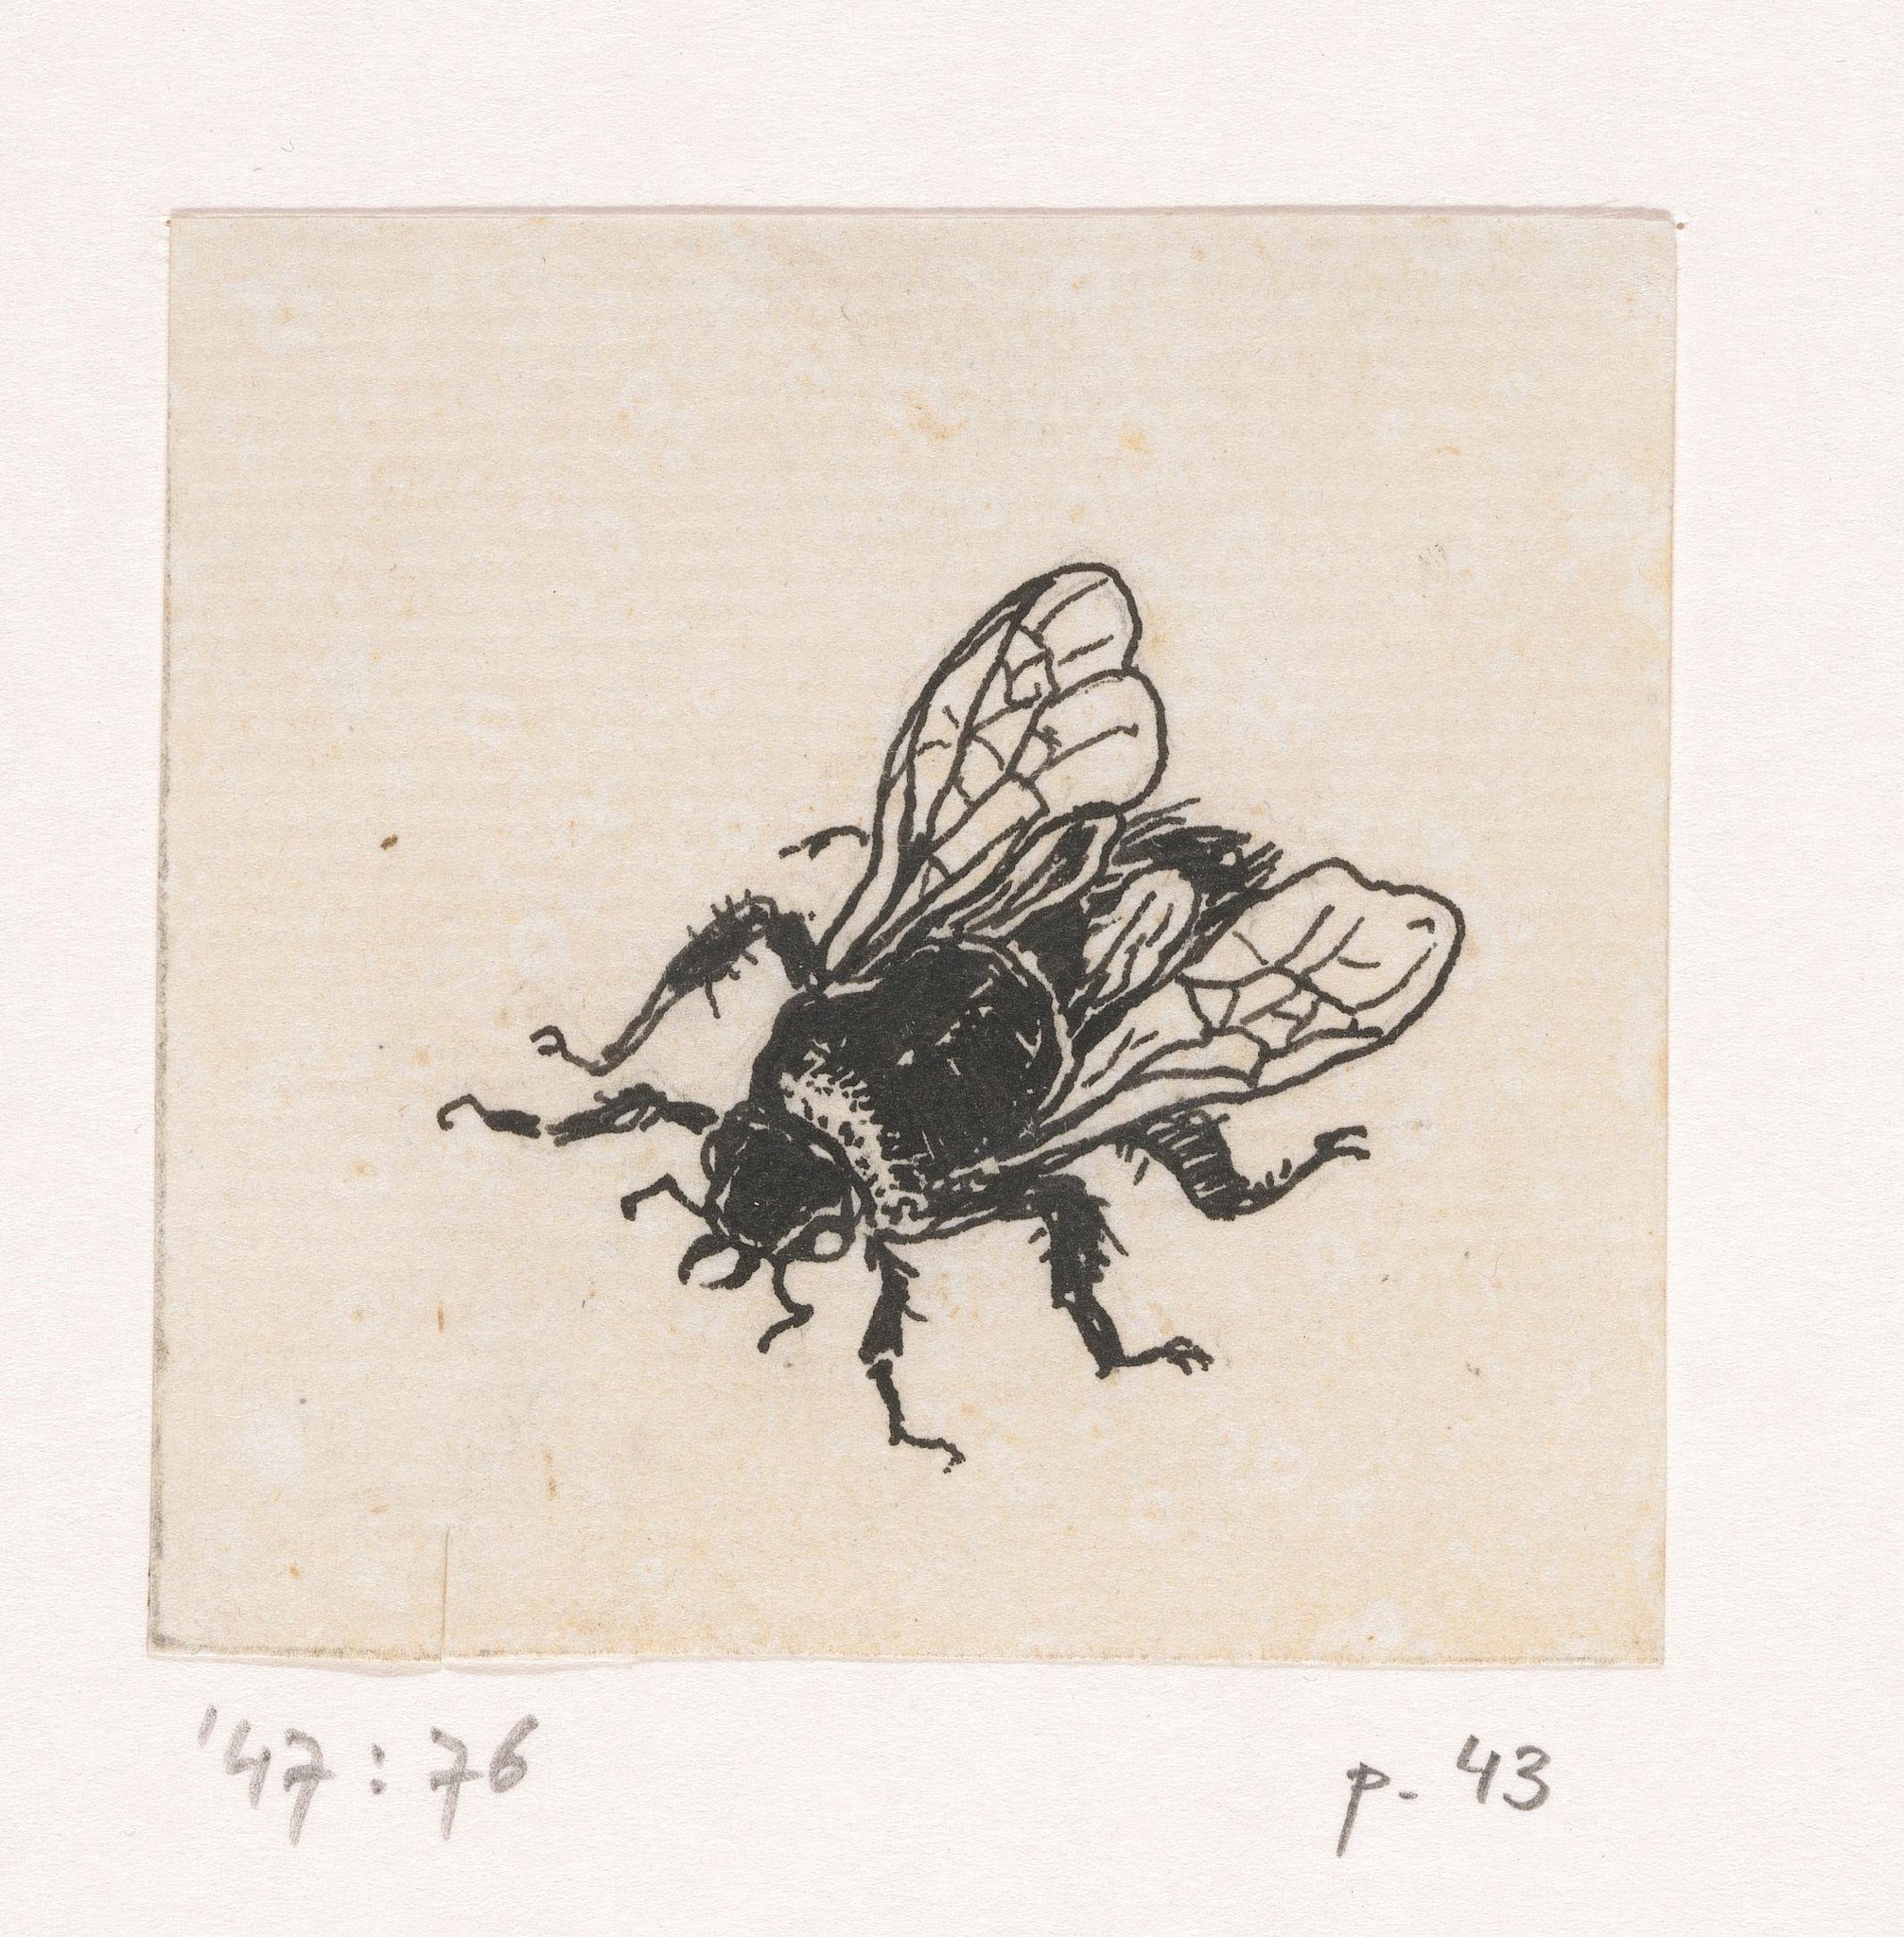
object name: drawing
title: Bij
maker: willem wenckebach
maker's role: designer, draughtsman, painter, print maker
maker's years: 1860-1937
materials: ink, paper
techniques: pen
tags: insects: bee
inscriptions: collector's mark: Lugt 2228a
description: Ontwerp voor: Knappert, Emilie C. Kijkjes in de plantenwereld. Loman & Funke: Amsterdam, 1893.